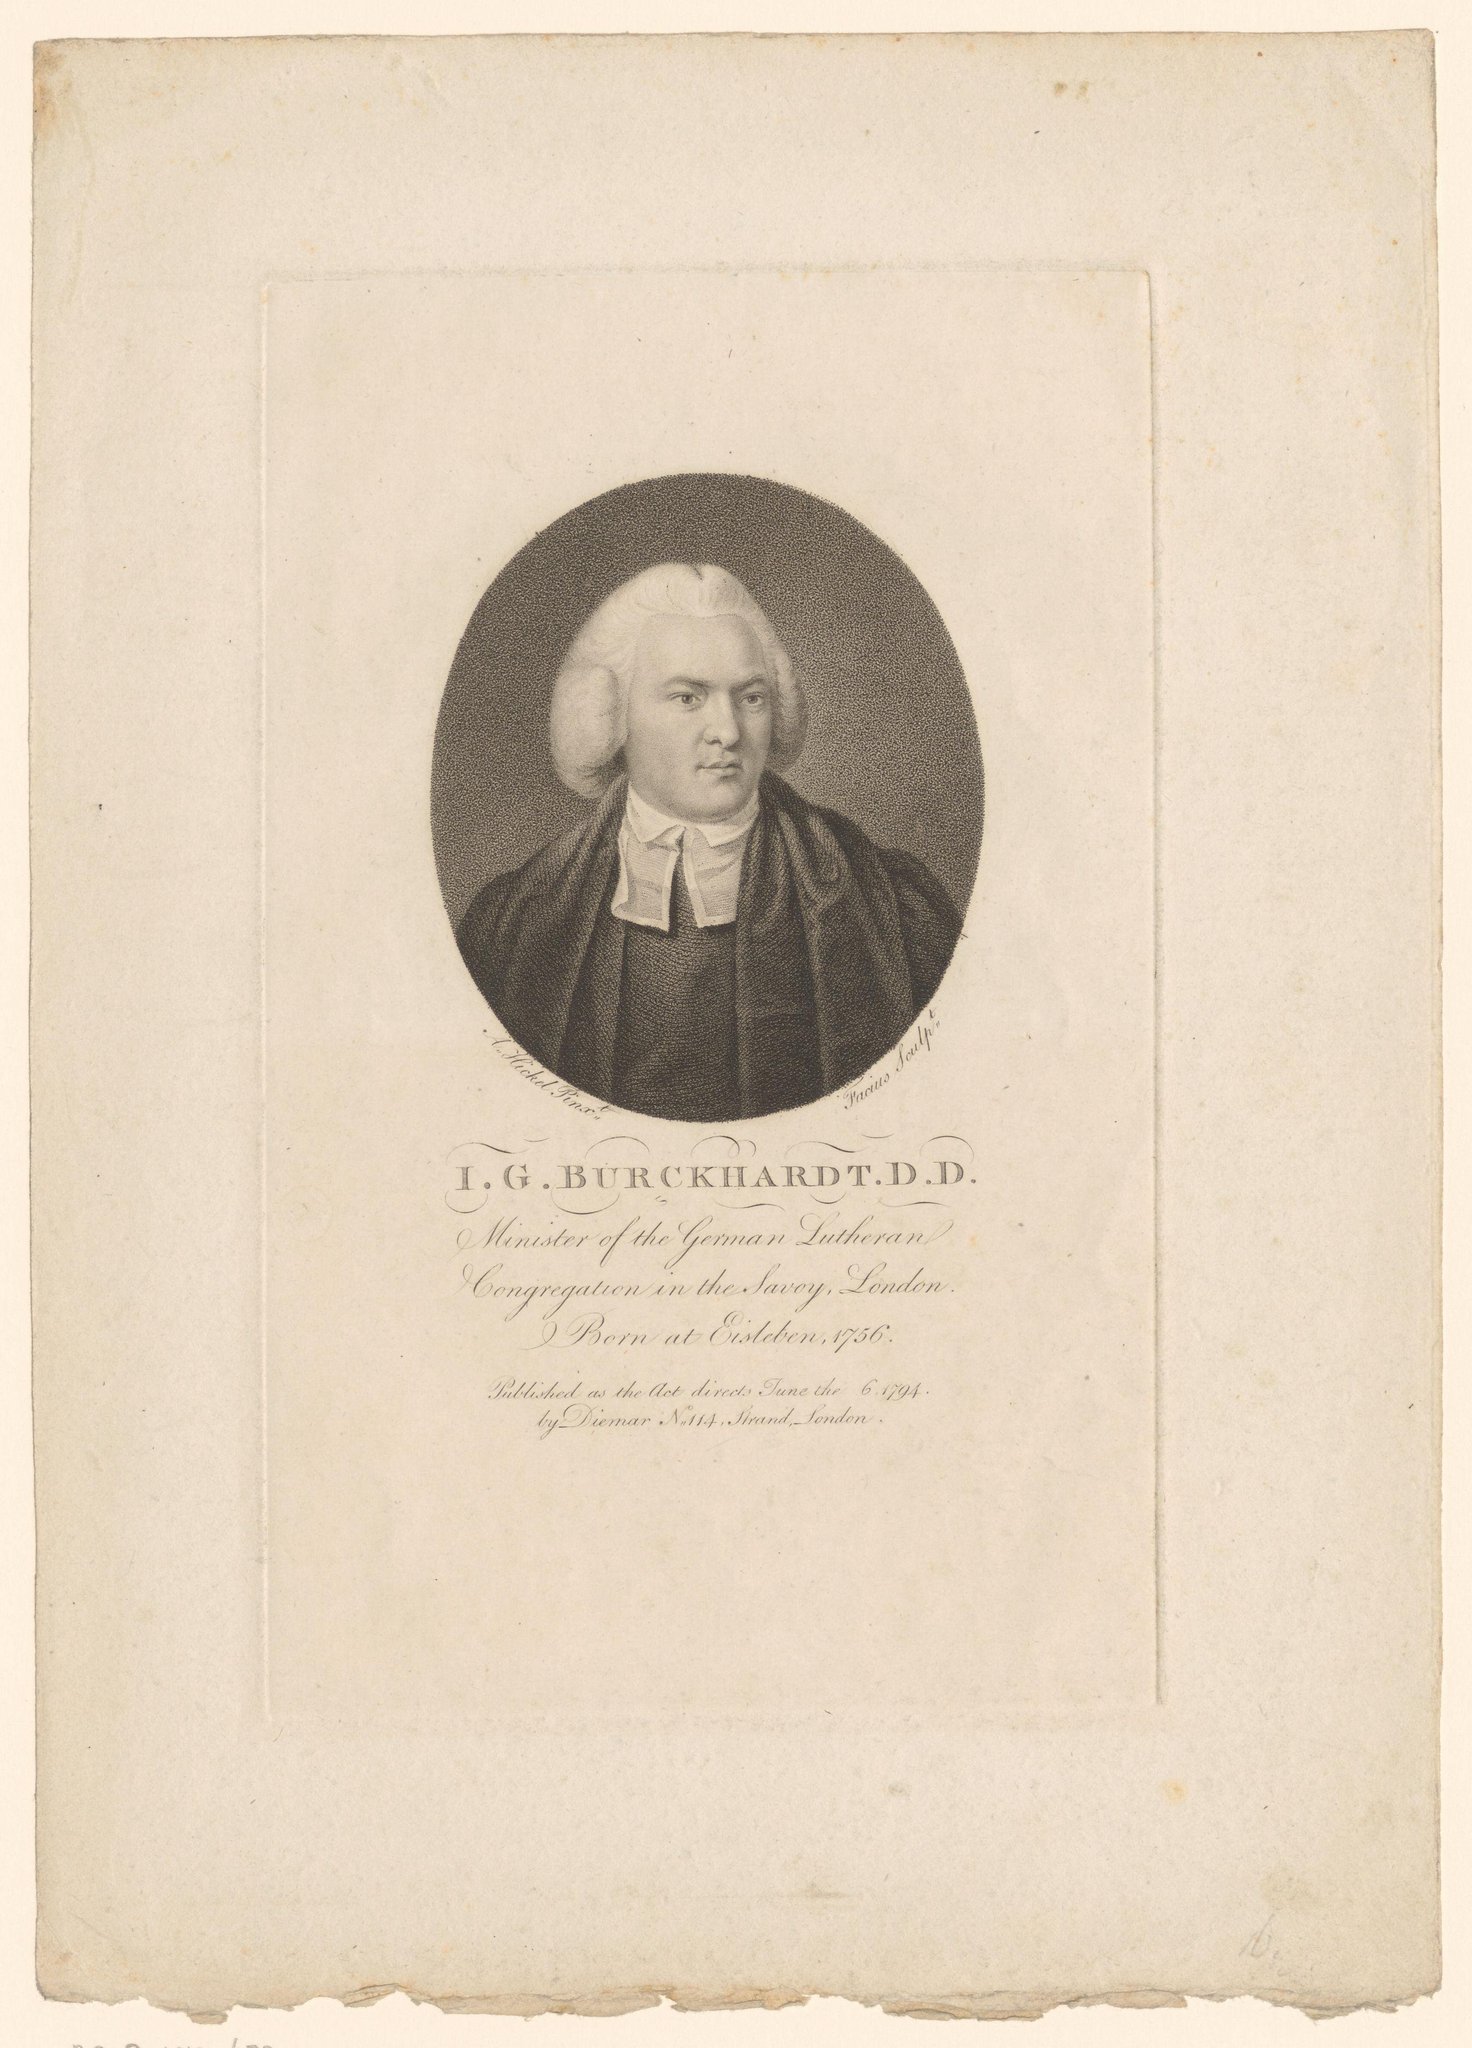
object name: print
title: I.G. Burckhardt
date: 1706-1794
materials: paper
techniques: stippling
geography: london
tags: functionaries and dignitaries (with name) ~ protestant churches, historical persons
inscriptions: collector's mark: Lugt 2228